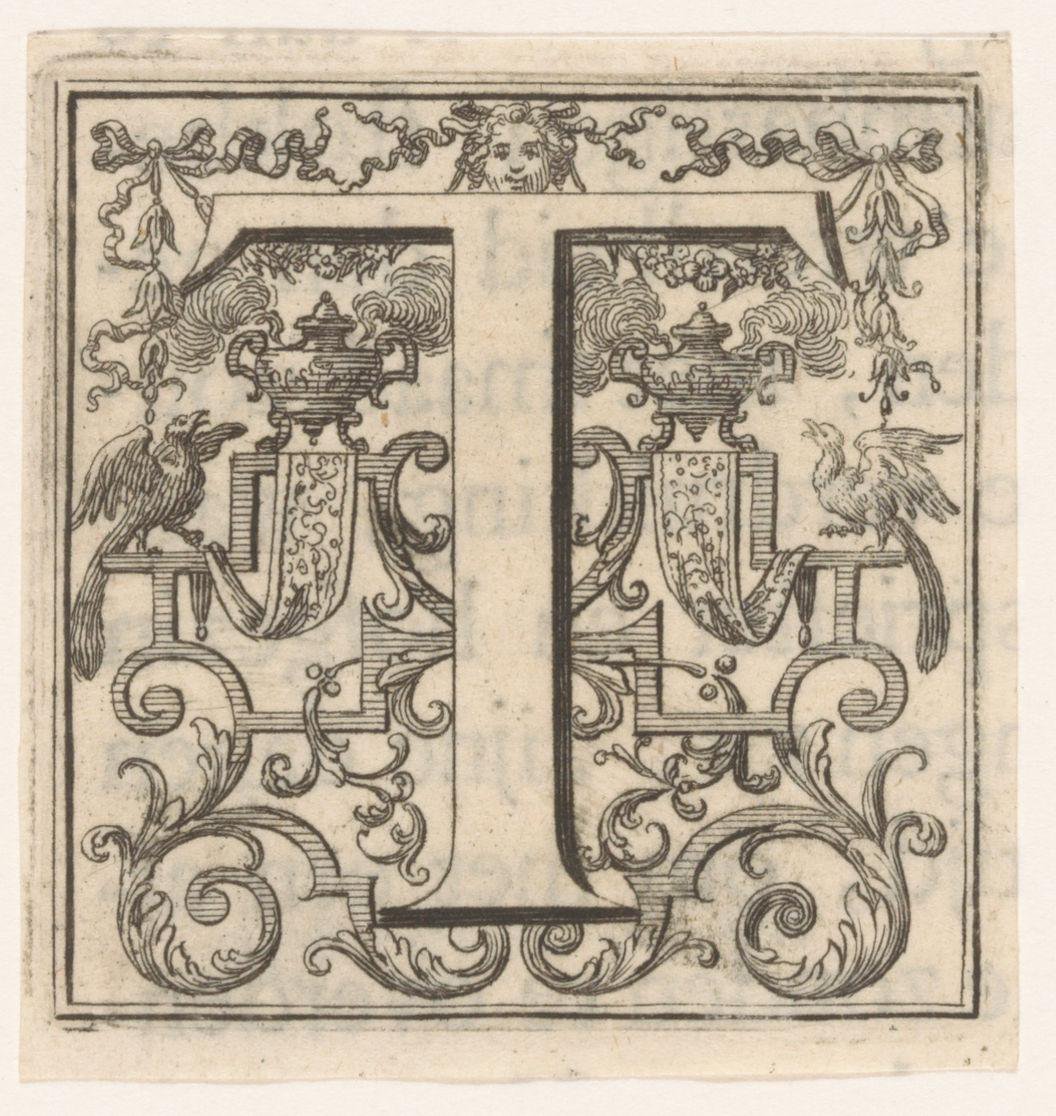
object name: book illustration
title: Letter T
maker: Anonymous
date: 1700-1799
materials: paper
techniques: etching, letterpress printing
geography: netherlands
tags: fancy letters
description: Letter T tegen een achtergrond met vlechtwerk, rookvaten en vogels.